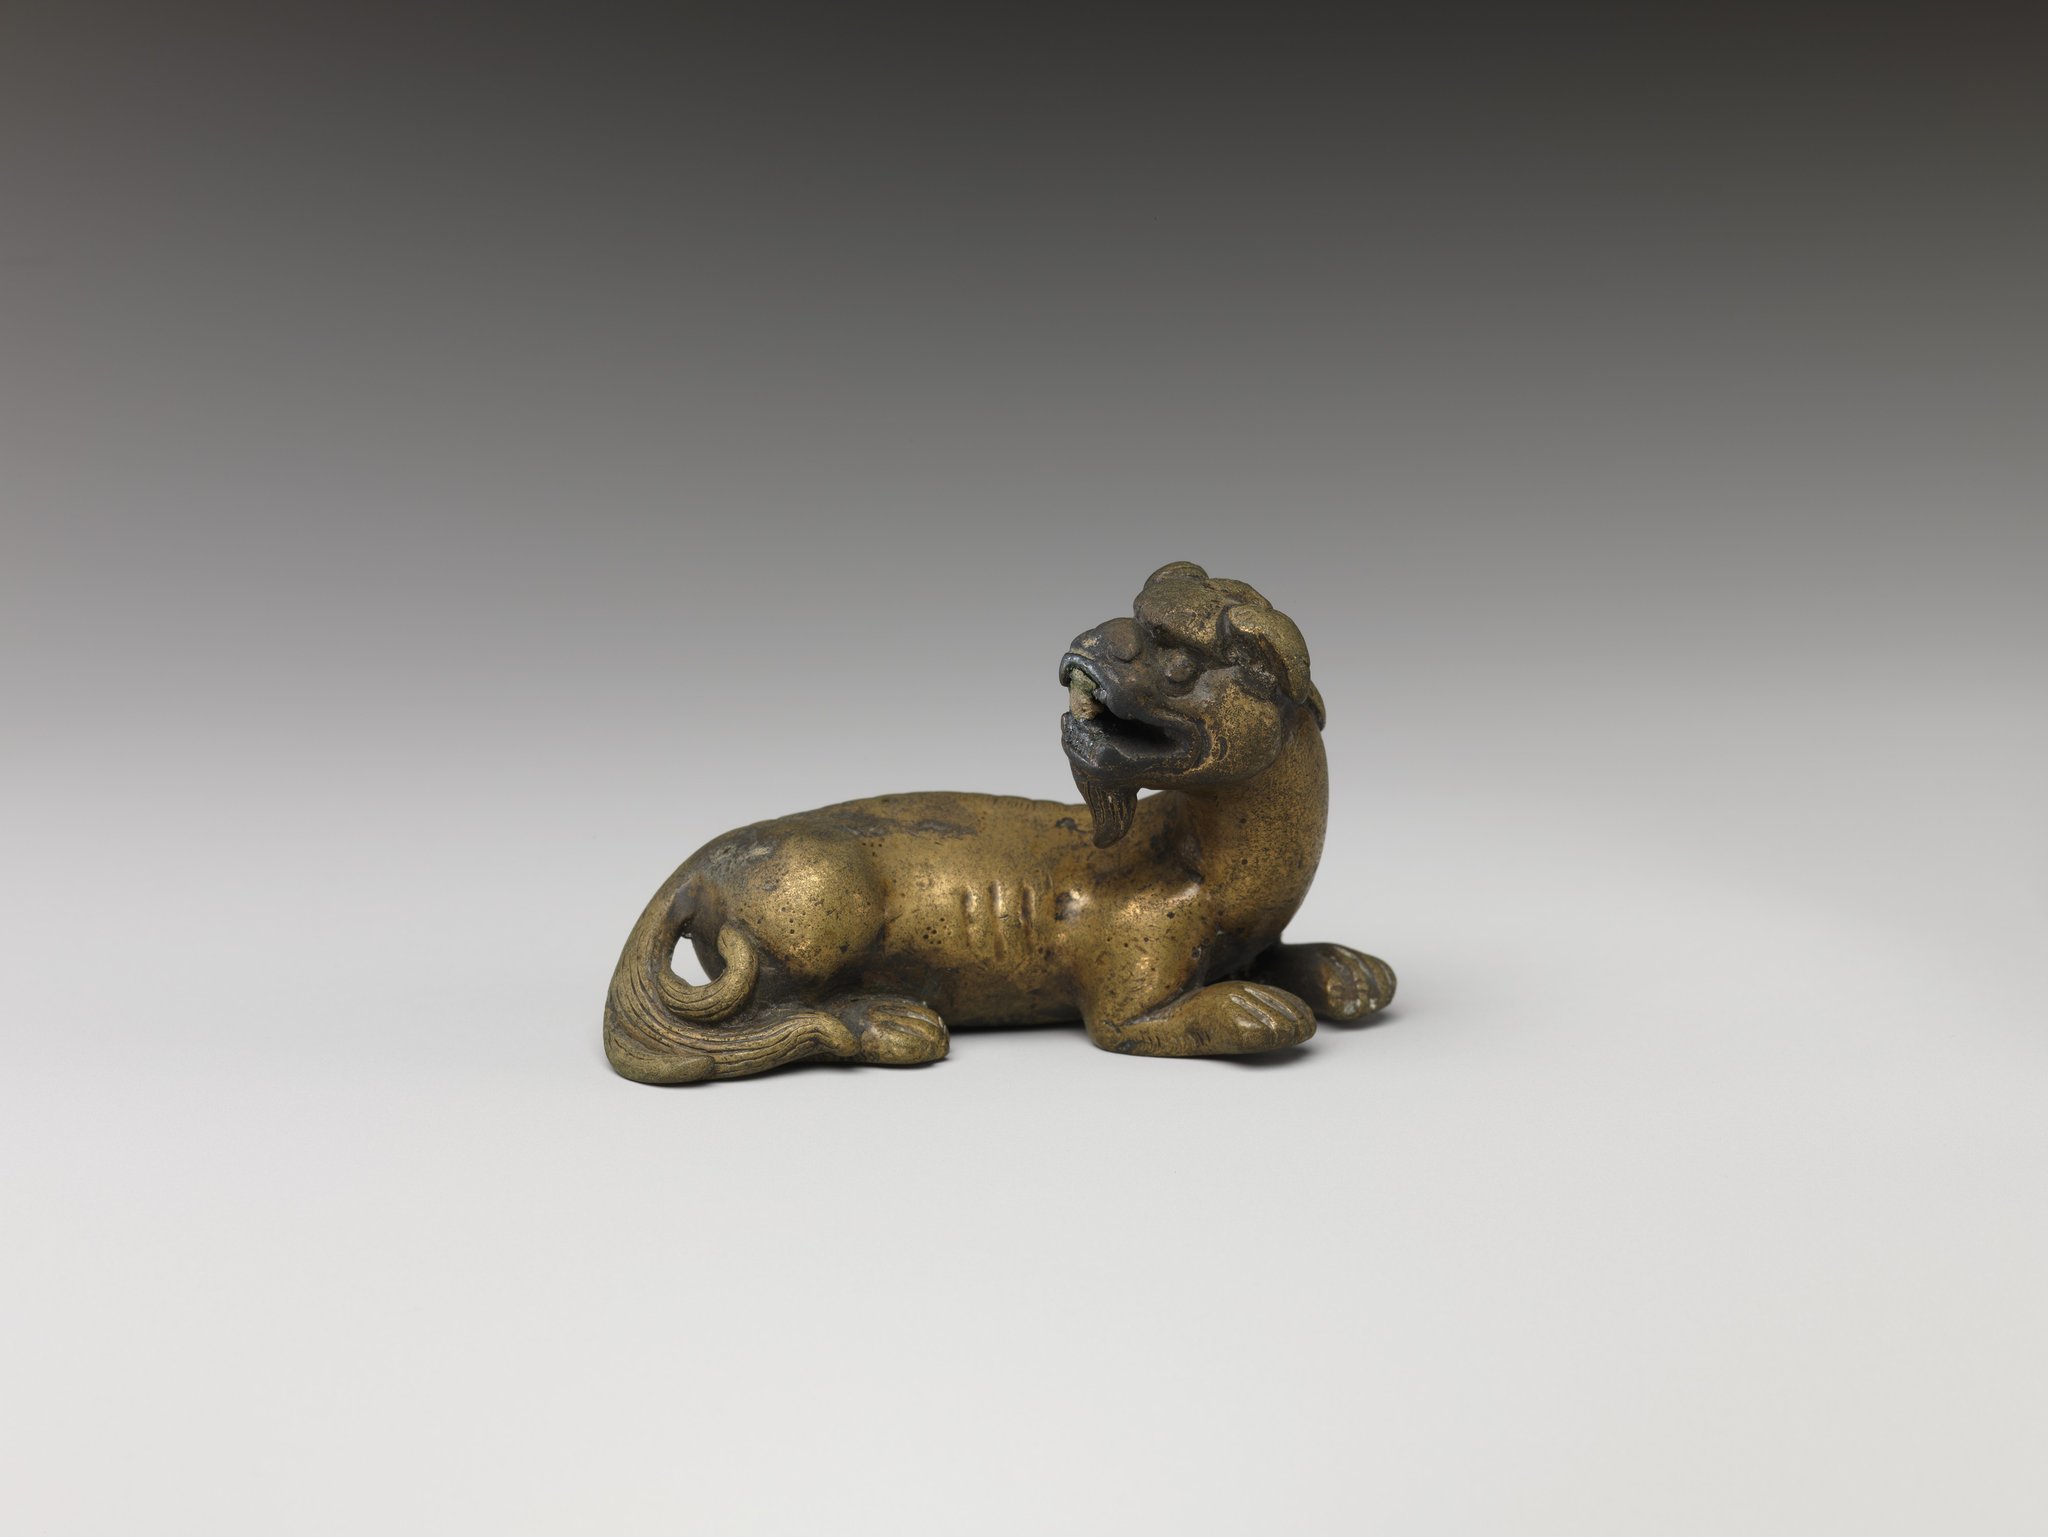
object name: figure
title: Lion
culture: chinese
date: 1701-1800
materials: brass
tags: lions